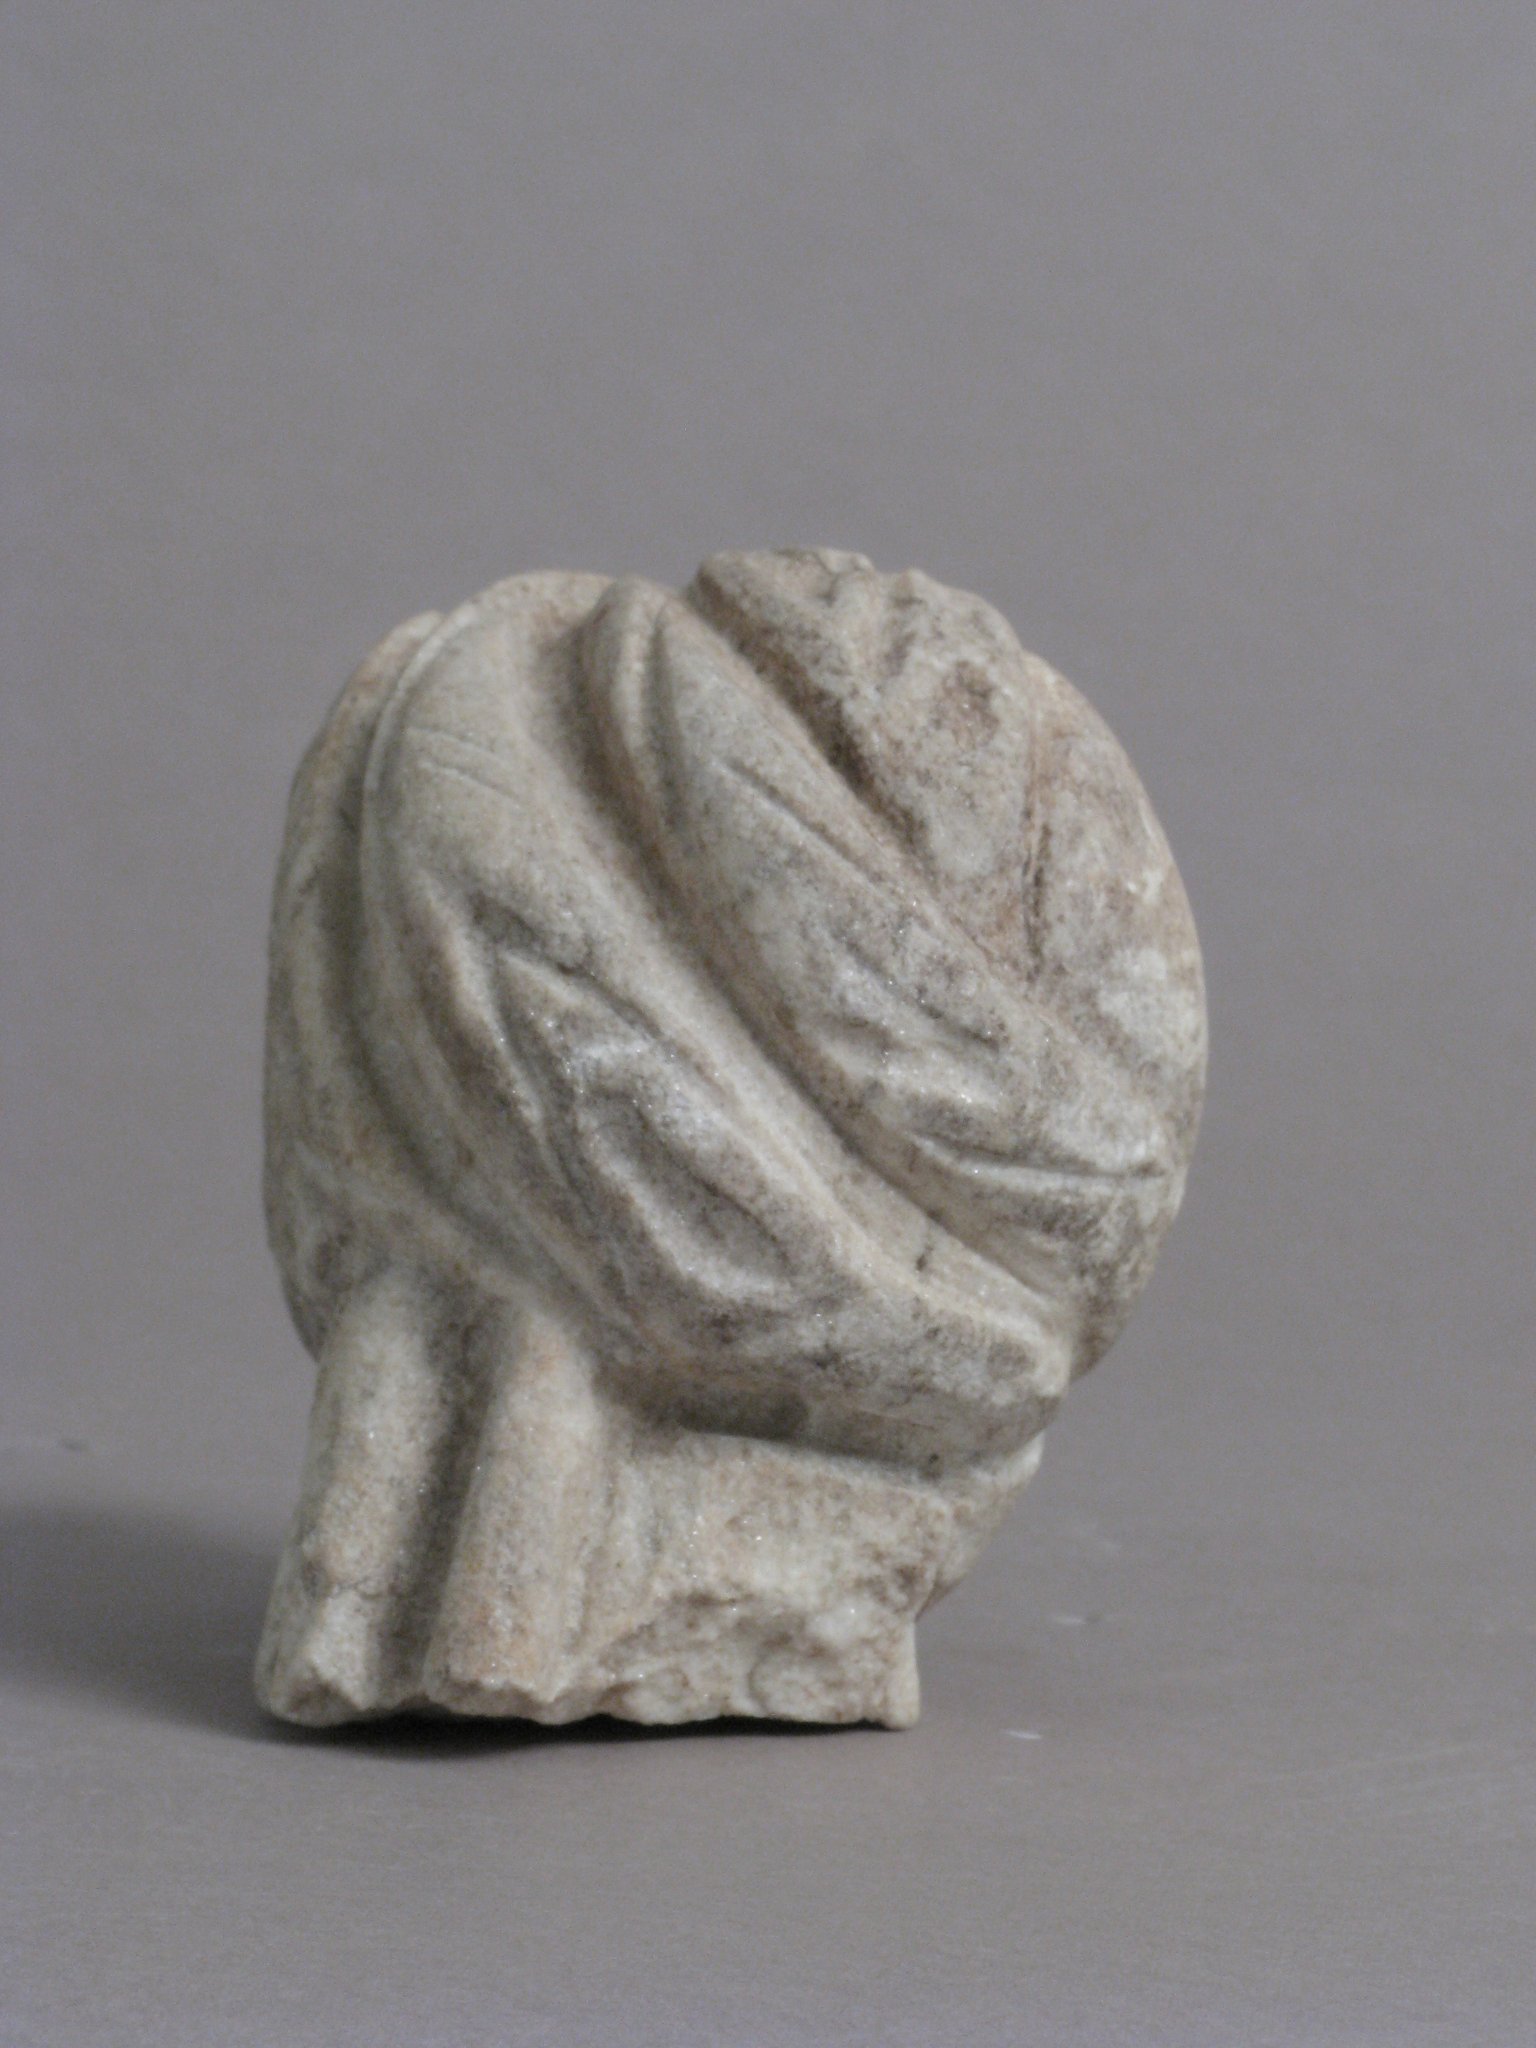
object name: statuette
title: Fragment of the Knot of a Tunic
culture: coptic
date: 301-700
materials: marble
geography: egypt